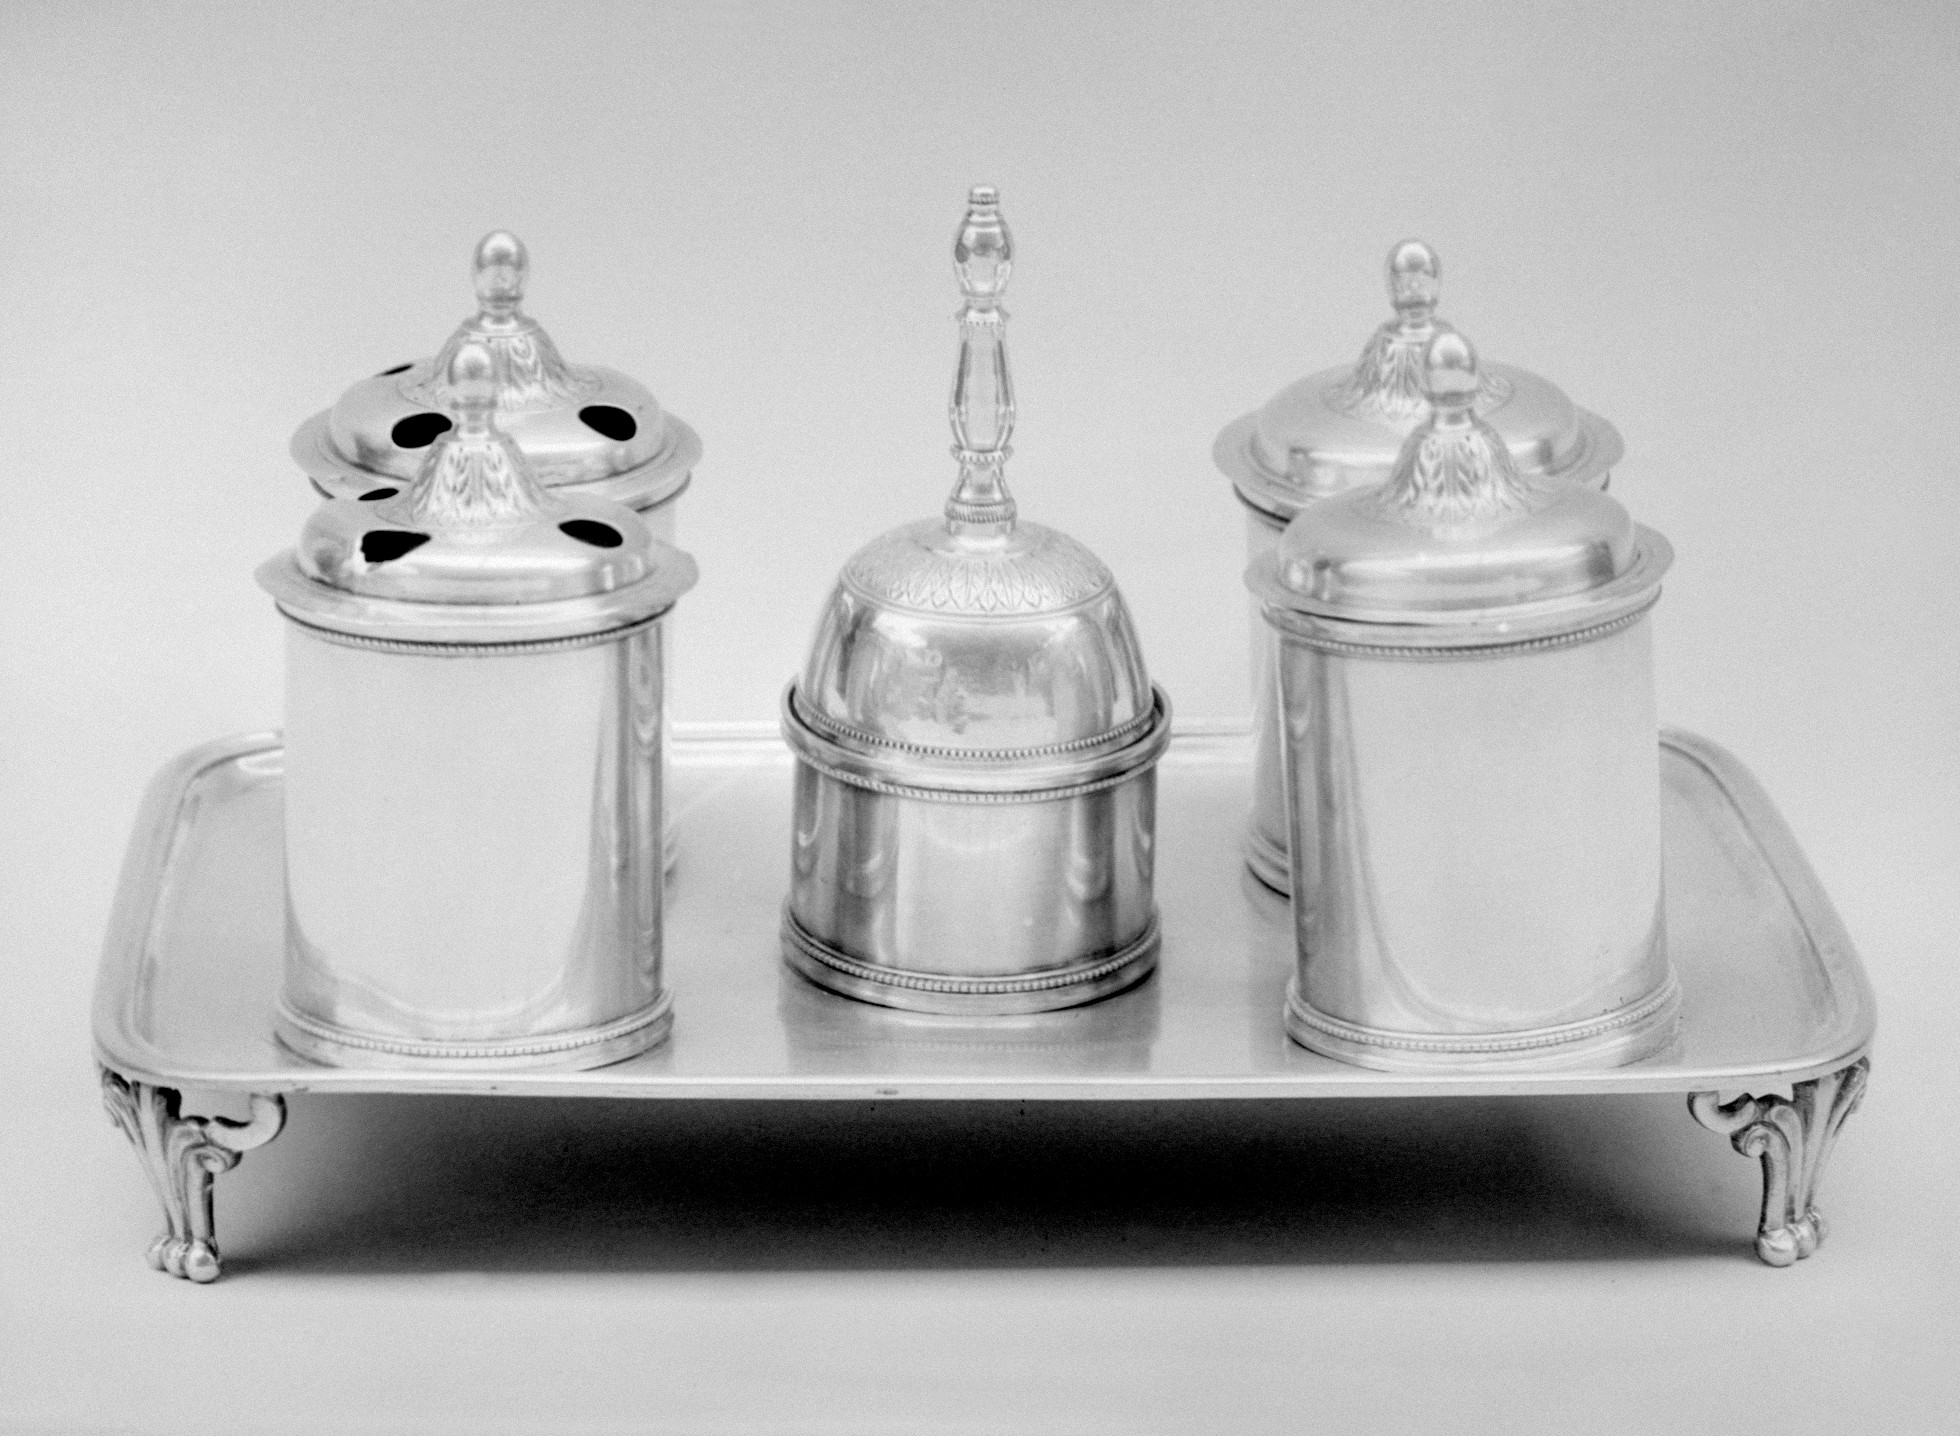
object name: inkstand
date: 1776-1800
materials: silver